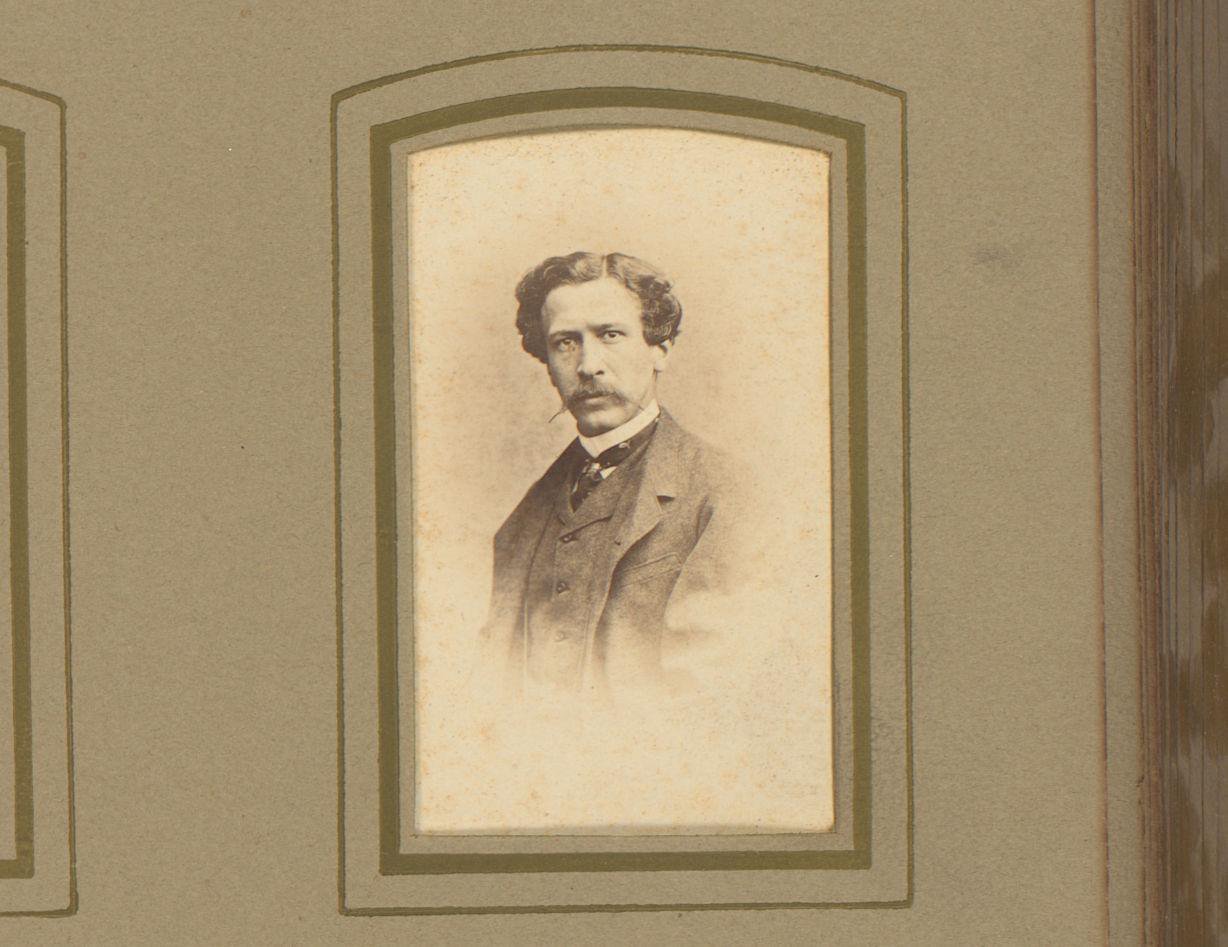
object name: album leaf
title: Portret van een man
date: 1860-1908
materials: cardboard, photographic support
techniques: albumen print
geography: amsterdam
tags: historical persons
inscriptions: number: ‘9’, inscription: ‘PHOTOGr ATELIER/ WEGNER & MOTTU/ Prinsengracht BB. 439/ AMSTERDAM’